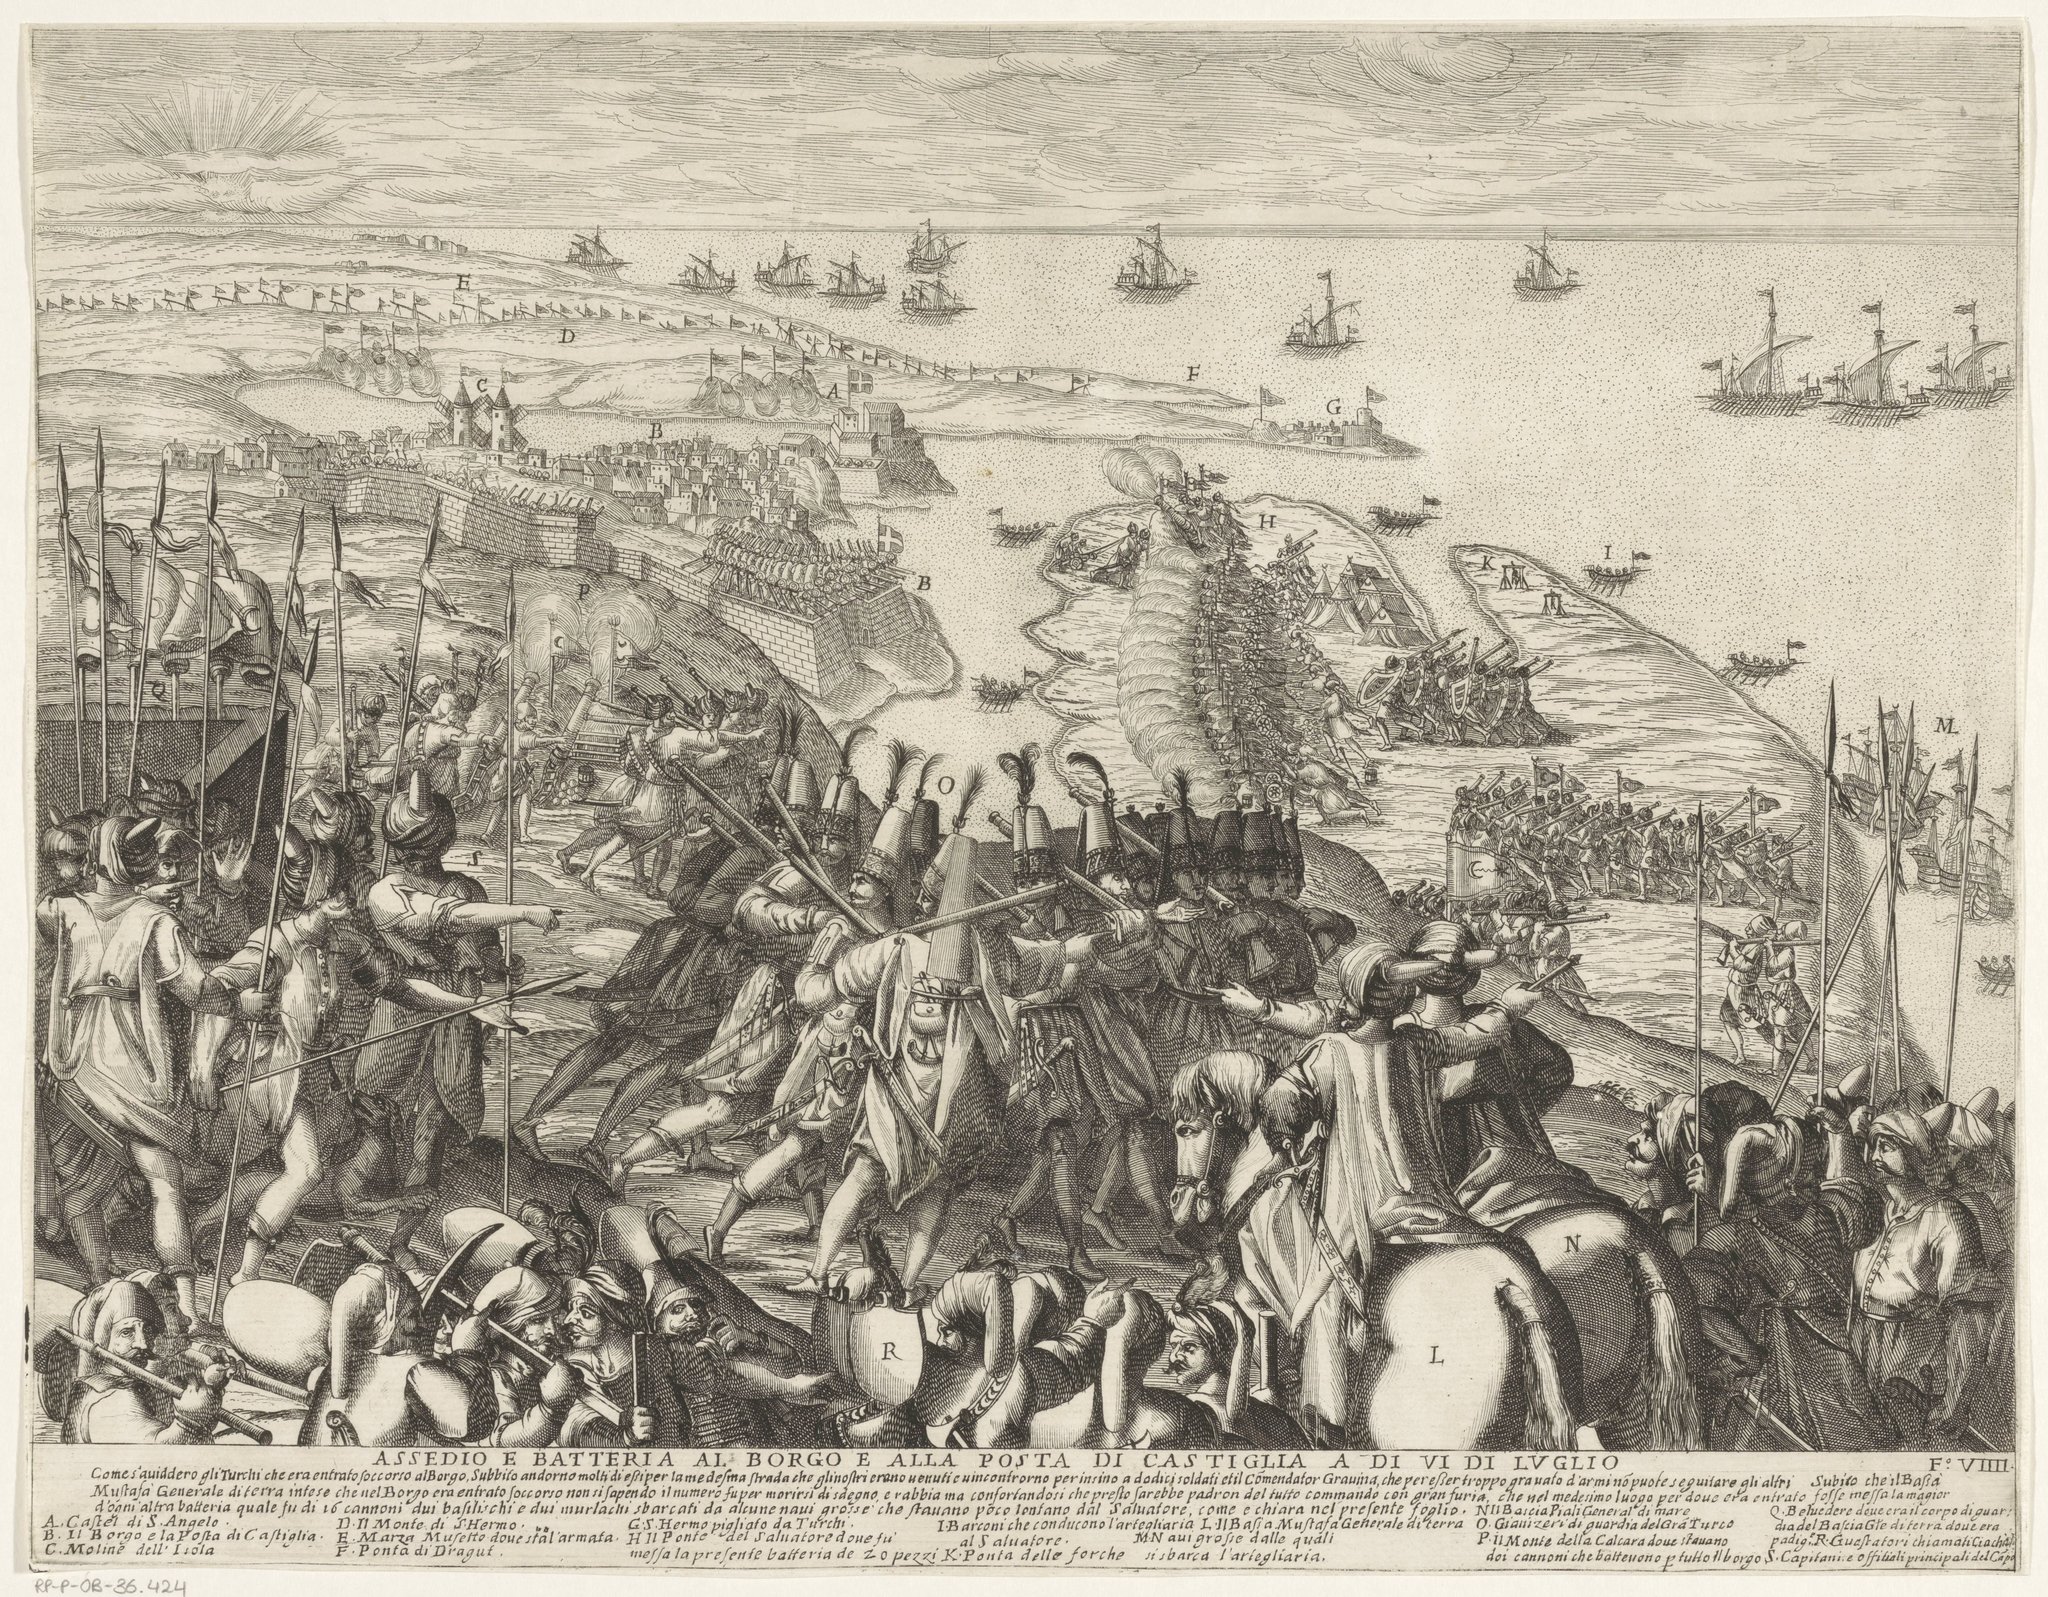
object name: print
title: Beleg van Castiglia op Malta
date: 1665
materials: paper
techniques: etching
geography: italy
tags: island, asiatic races and peoples: turks, the soldier; the soldier's life, battle (+ land forces)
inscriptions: collector's mark: Lugt 2228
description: Het Beleg van Castiglia op Malta. Maltezer soldaten in strijd met Turkse soldaten. Italiaanse tekst en verklarende lijst met nummers in ondermarge. Genummerd rechtsonder: VIIII.